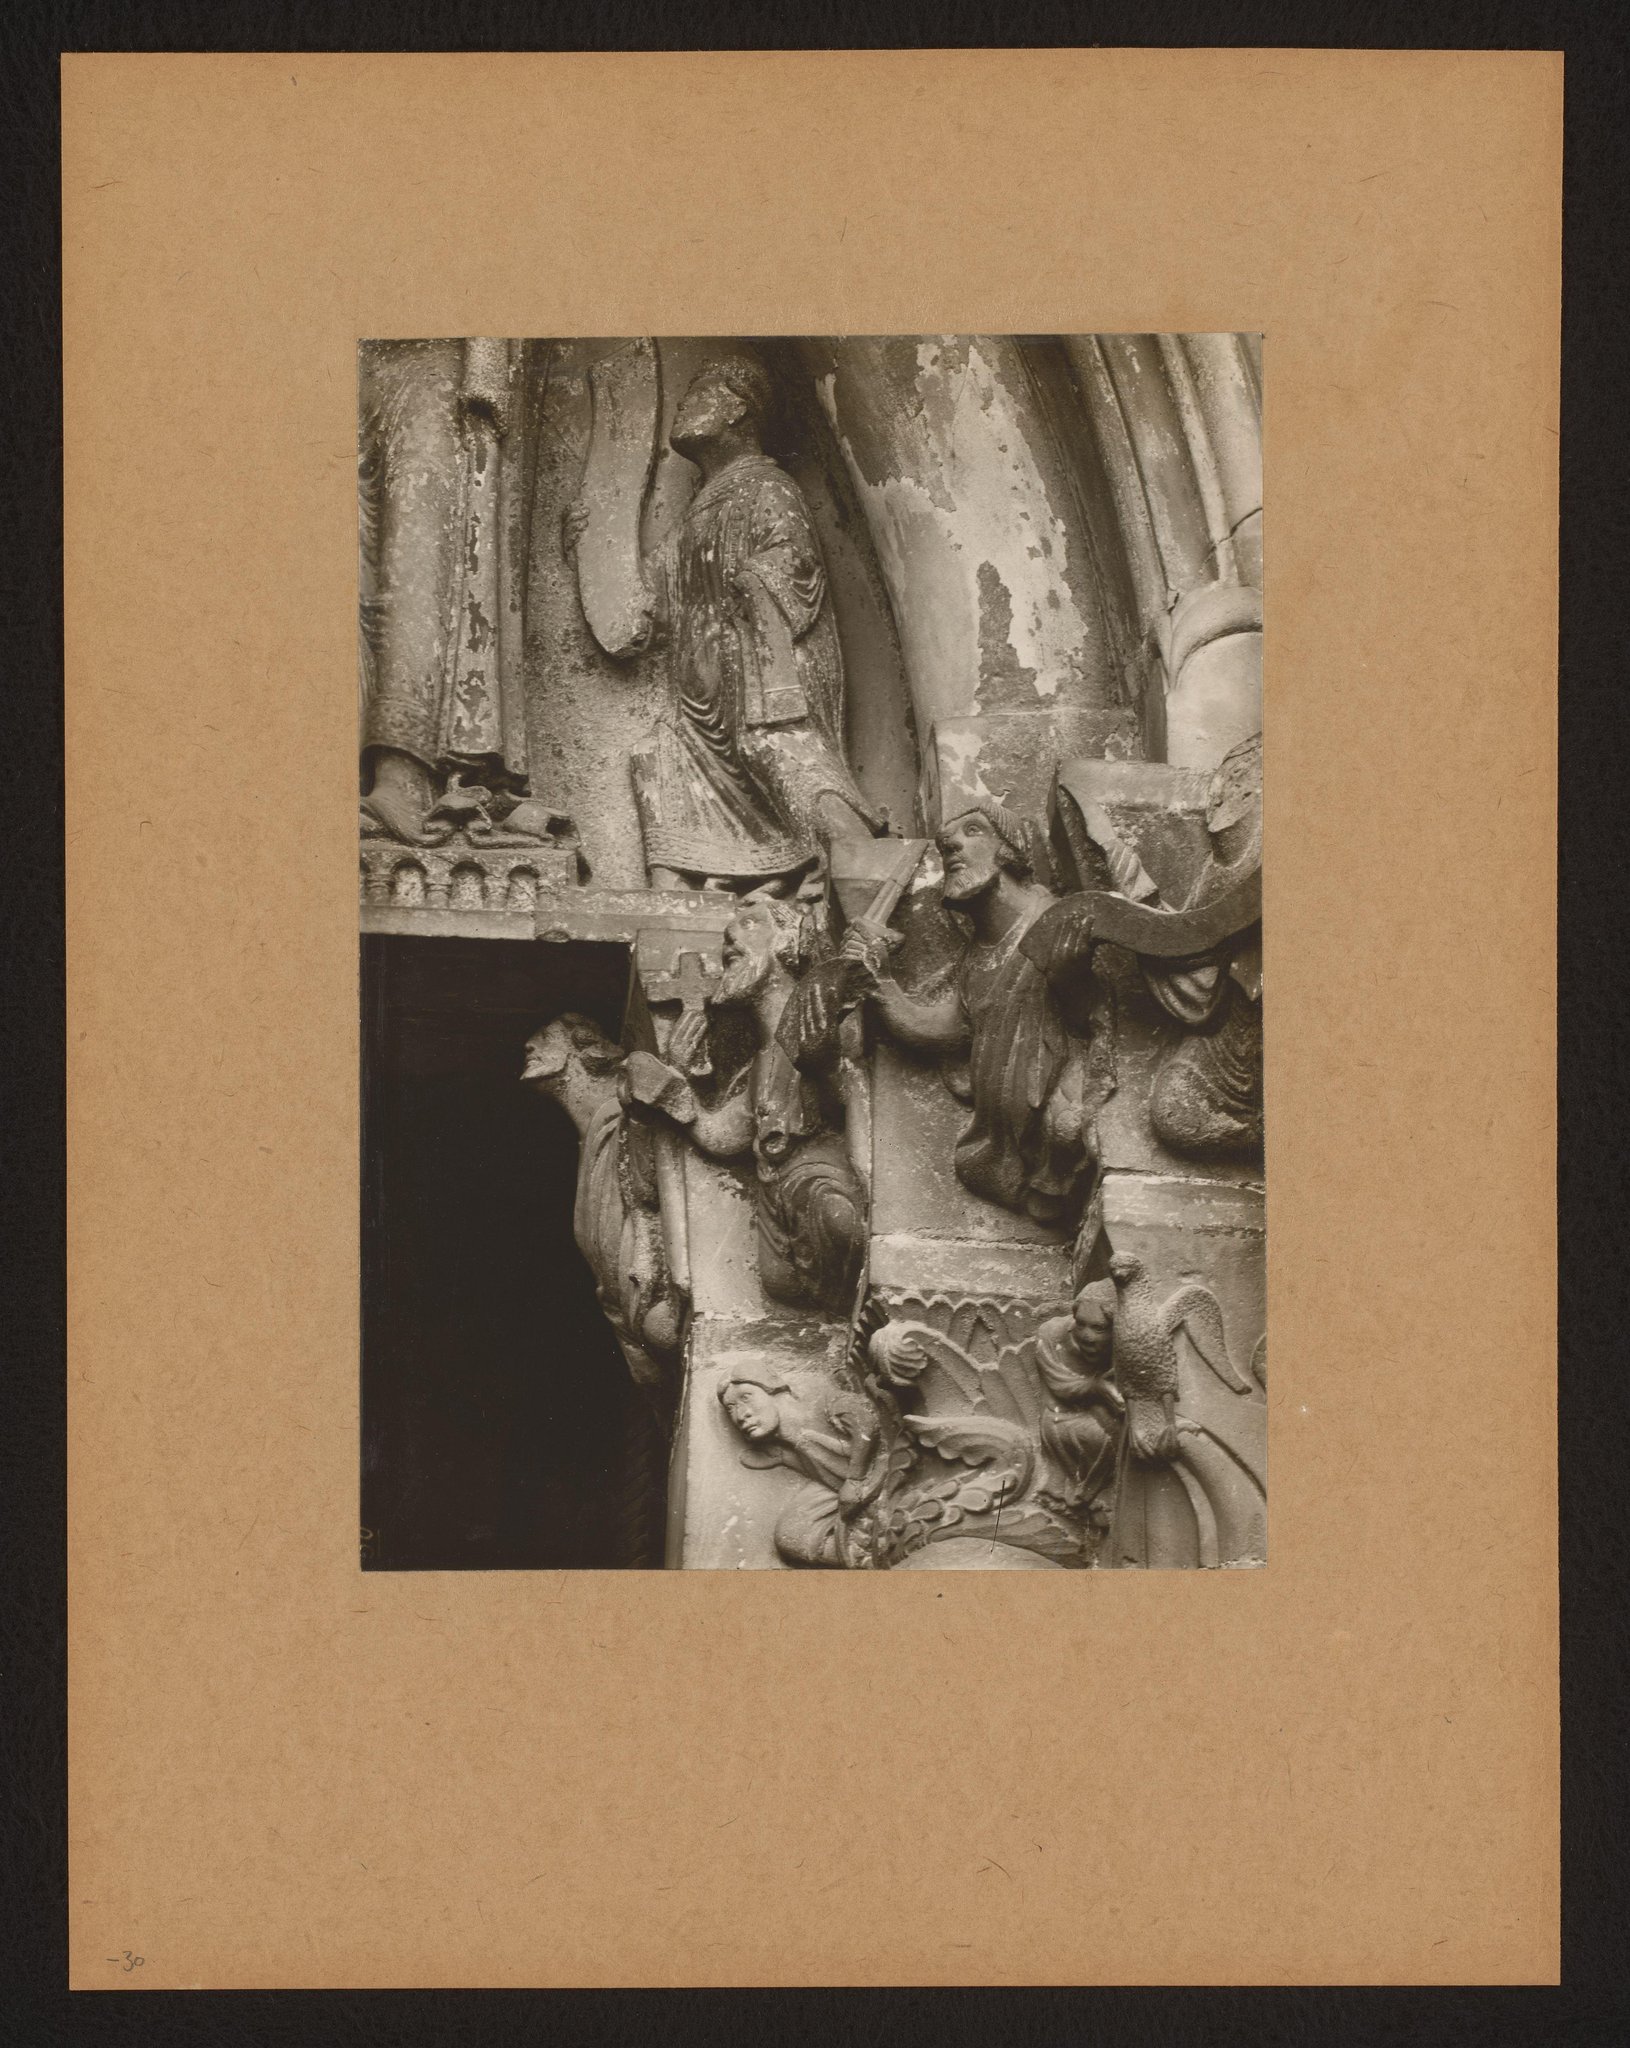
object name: photograph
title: Marienpforte, r. Kapitellzone, li v.O.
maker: Anonymous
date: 1900-1920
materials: paper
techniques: gelatin silver print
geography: bamberg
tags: church (exterior)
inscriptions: number: ‘30.’